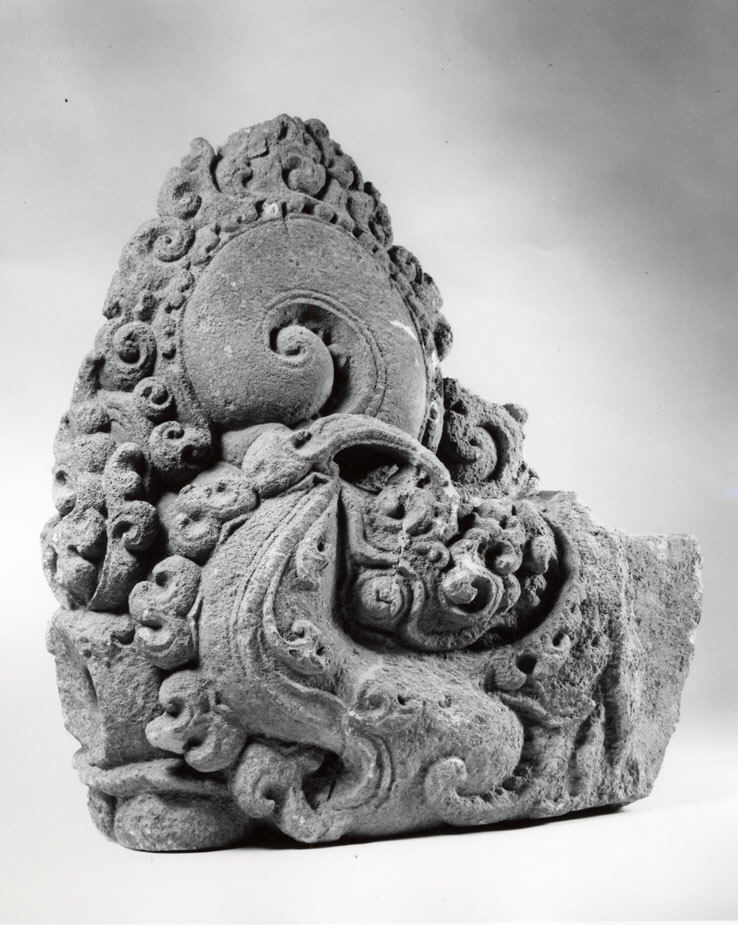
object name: water spout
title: Water Spout in the Form of a Makara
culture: indonesian, javanese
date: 901-1000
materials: stone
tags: hinduism